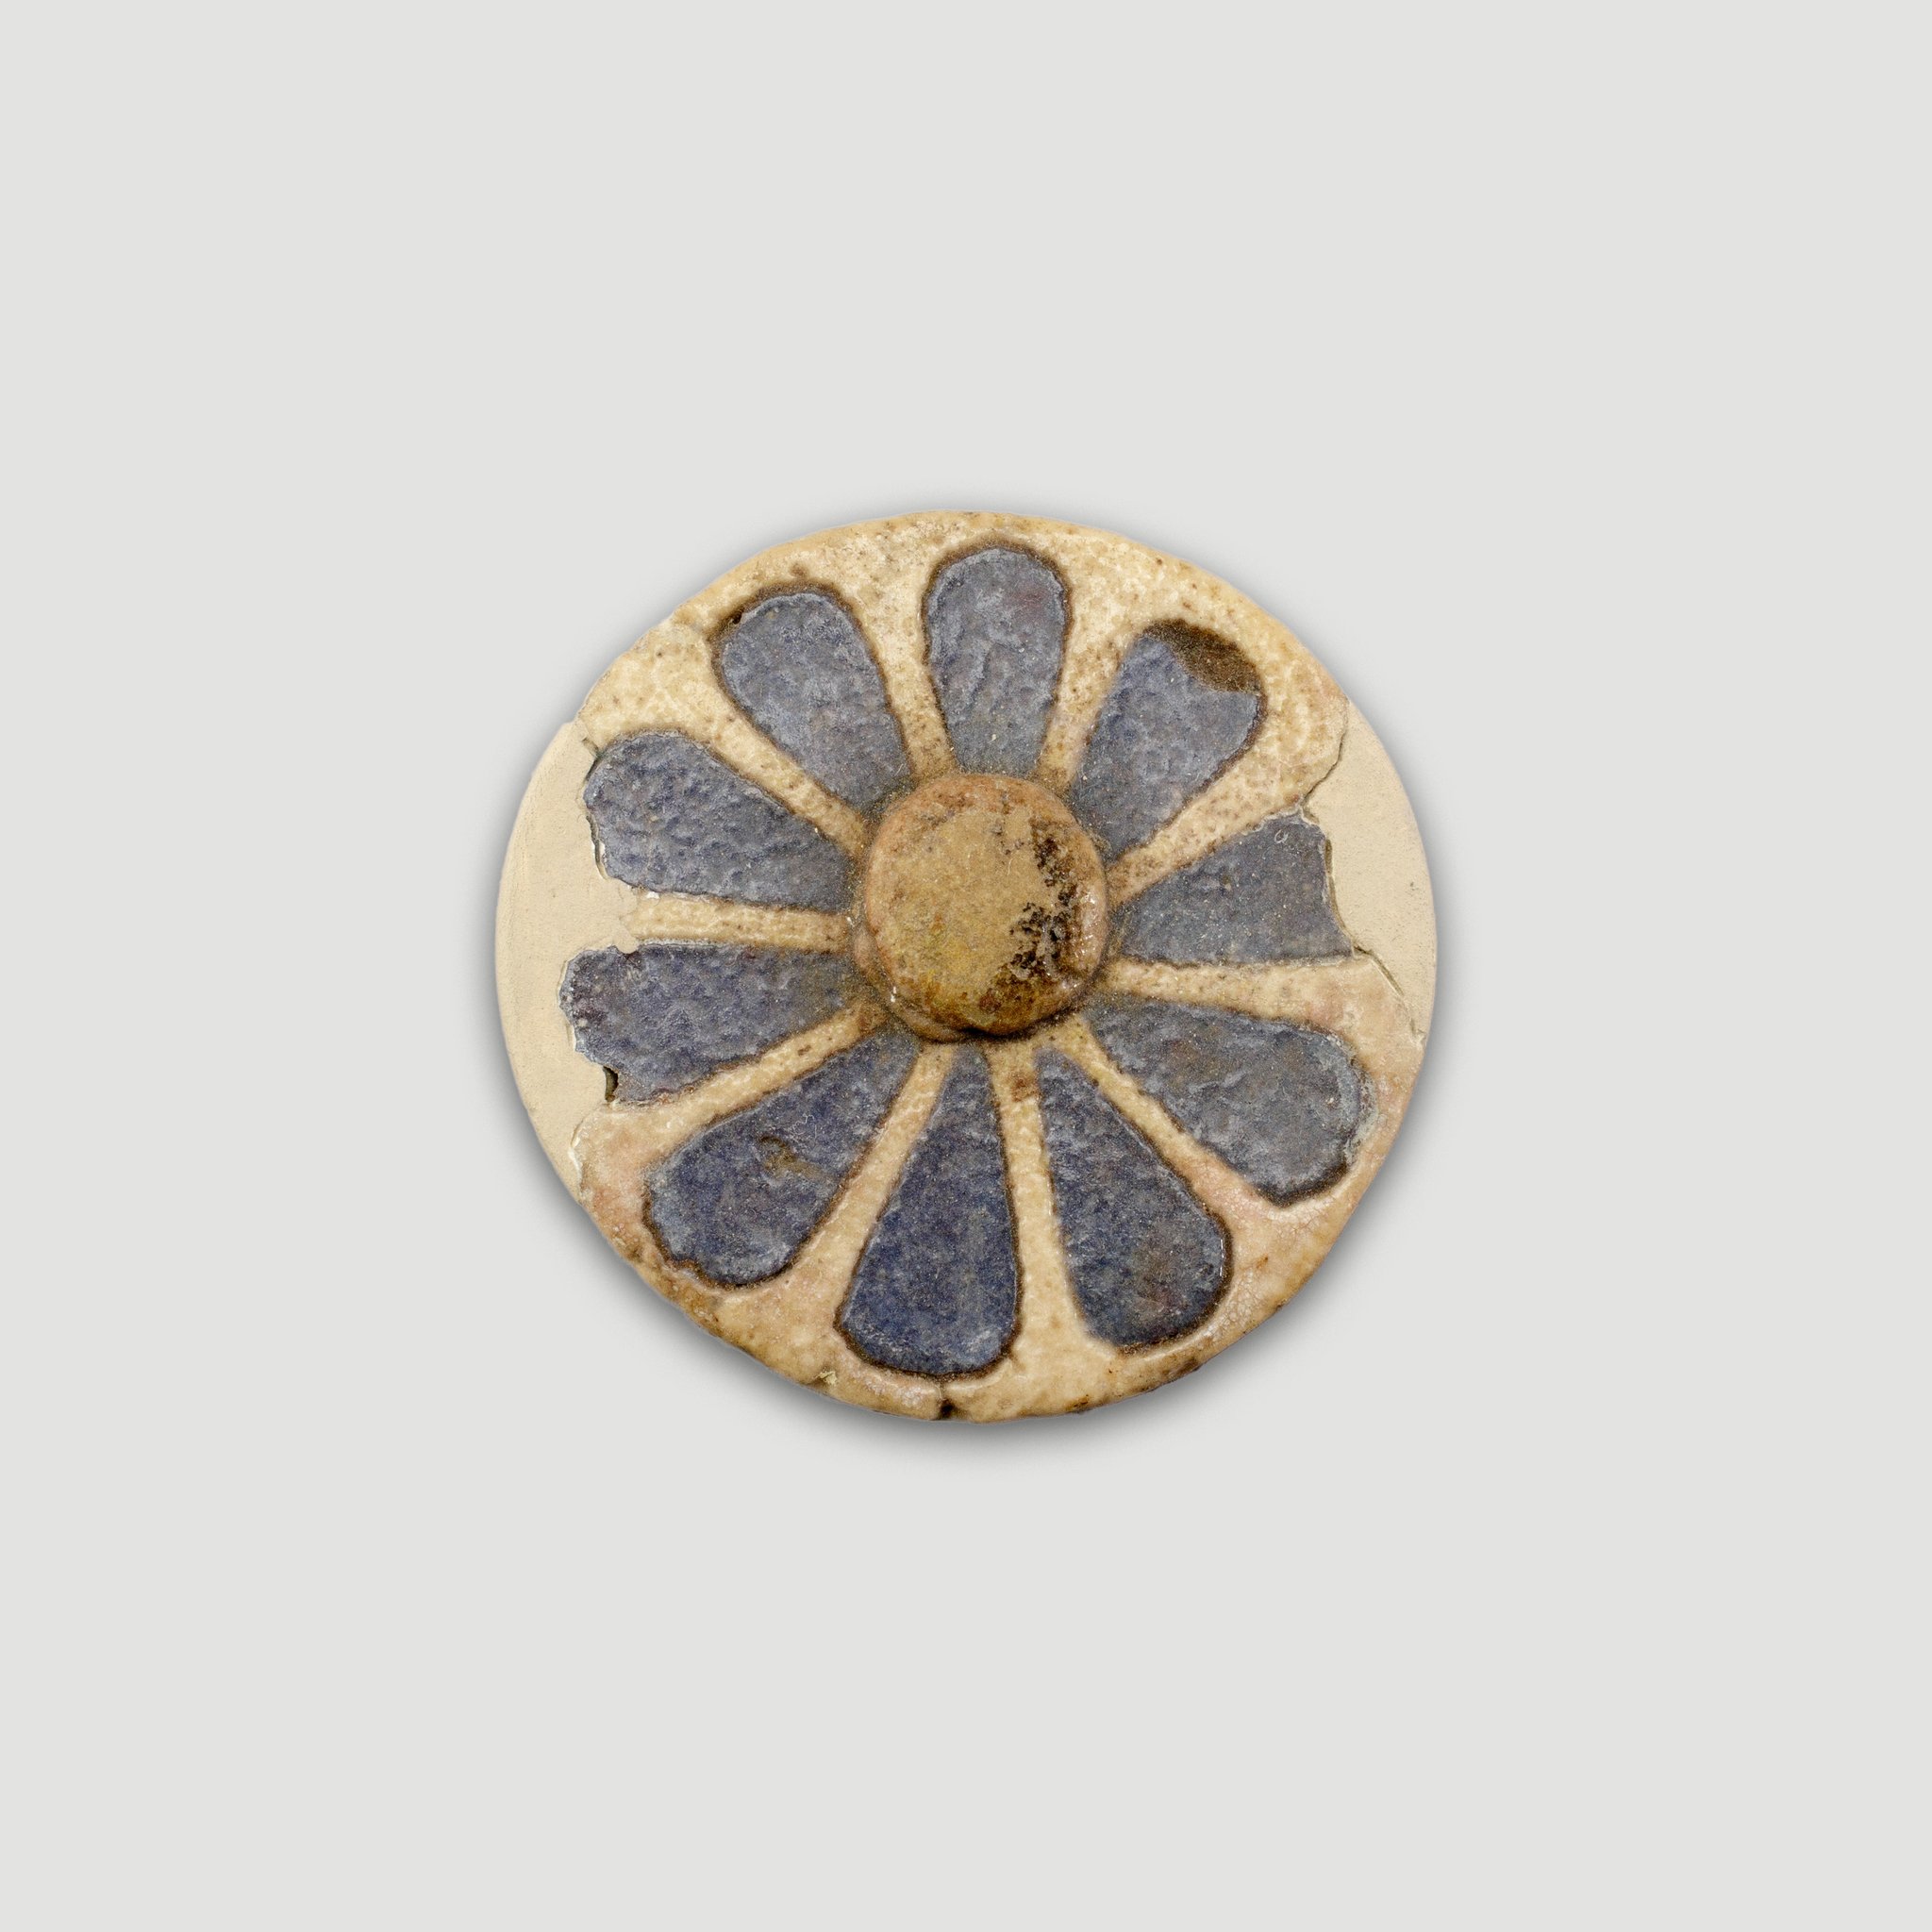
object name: tile, palace of ramesses ii, rosette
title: Glazed disk in the shape of rosette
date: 1279-1213 BCE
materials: faience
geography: egypt